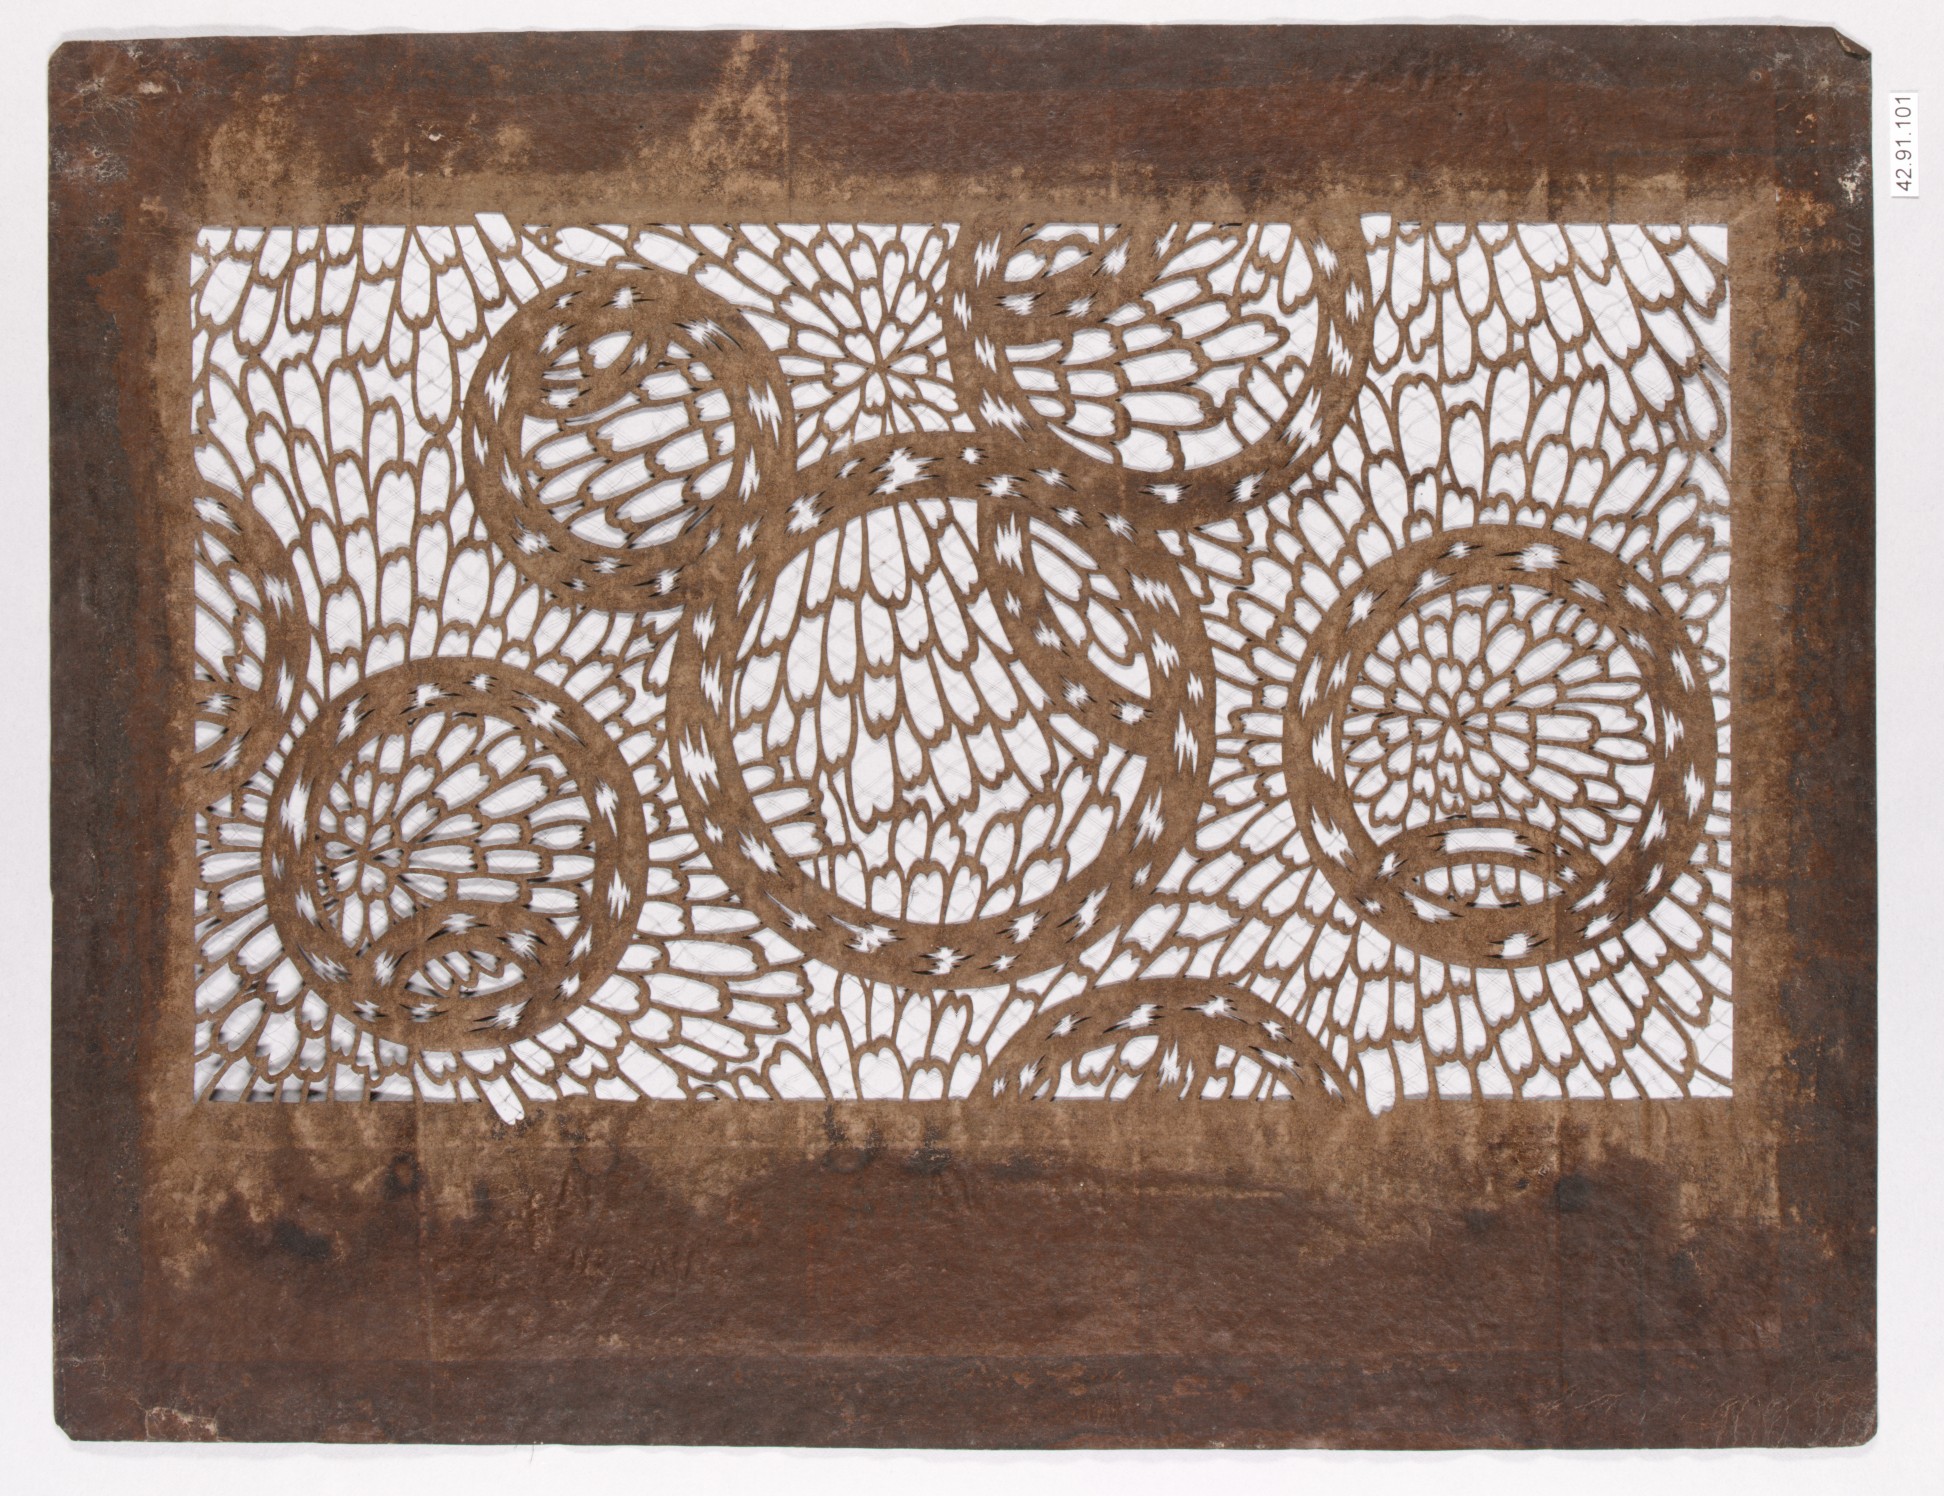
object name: stencil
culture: japanese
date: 1801-1900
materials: paper, silk